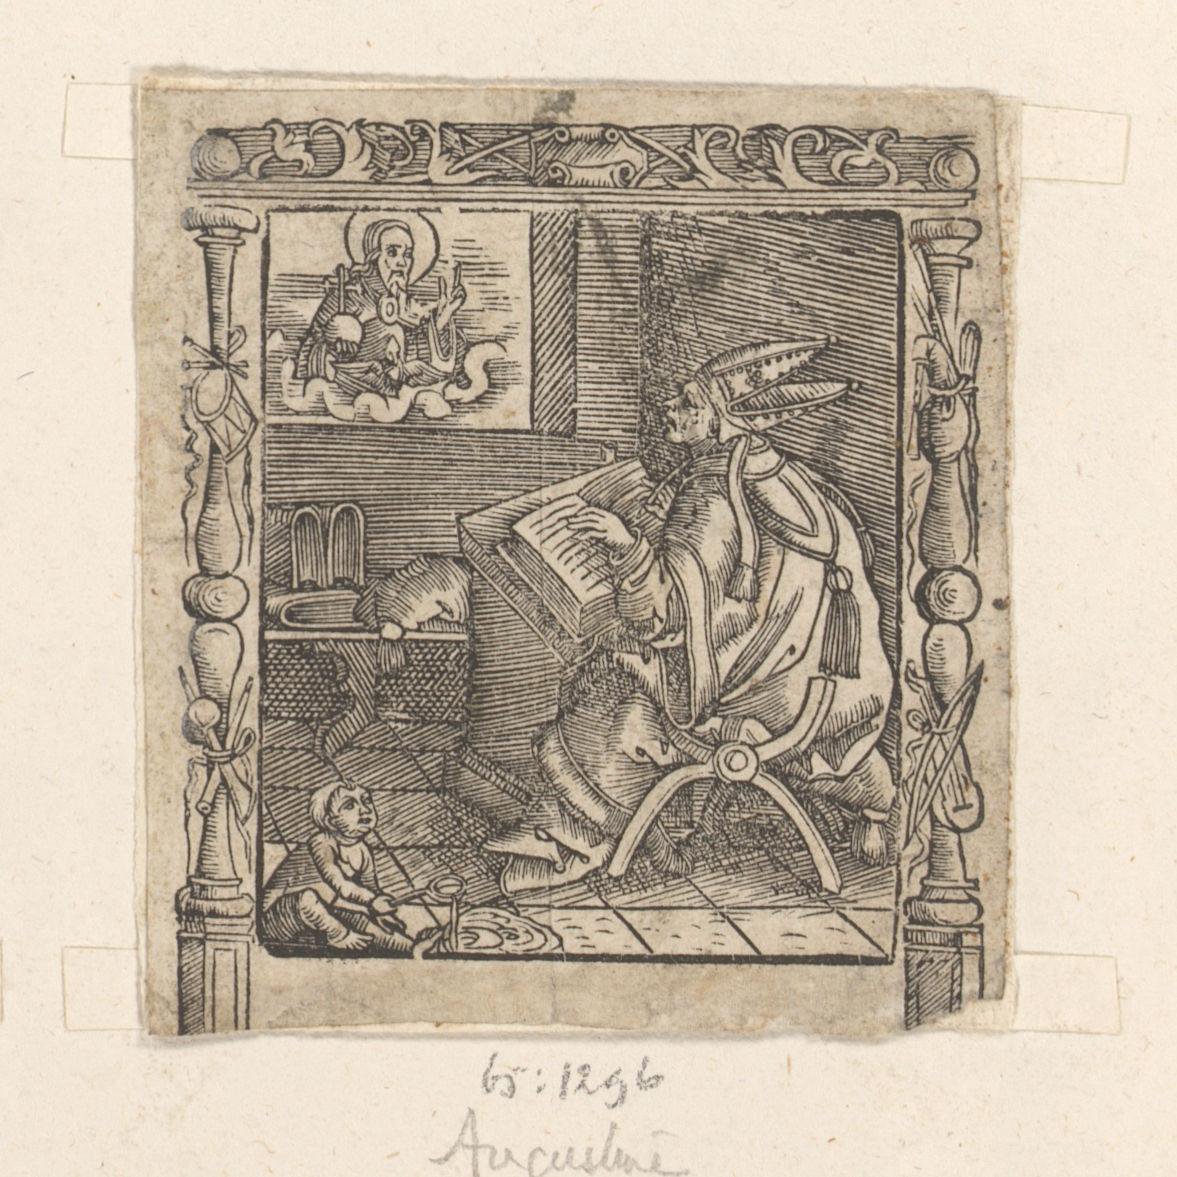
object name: album leaf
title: Christus verschijnt aan kerkvader Augustinus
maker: erhard schön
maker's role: draughtsman, print maker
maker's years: 1491-1542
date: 1515-1517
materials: paper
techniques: woodcut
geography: nuremberg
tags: augustine, bishop of hippo; possible attributes: arrows piercing his breast, book, child with spoon, flaming heart, heart (pierced with arrows), pen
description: Christus verschijnt aan kerkvader Augustinus, die in zijn boek schrijft. Augustinus is gekleed als bisschop. Prent maakt deel uit van een album.